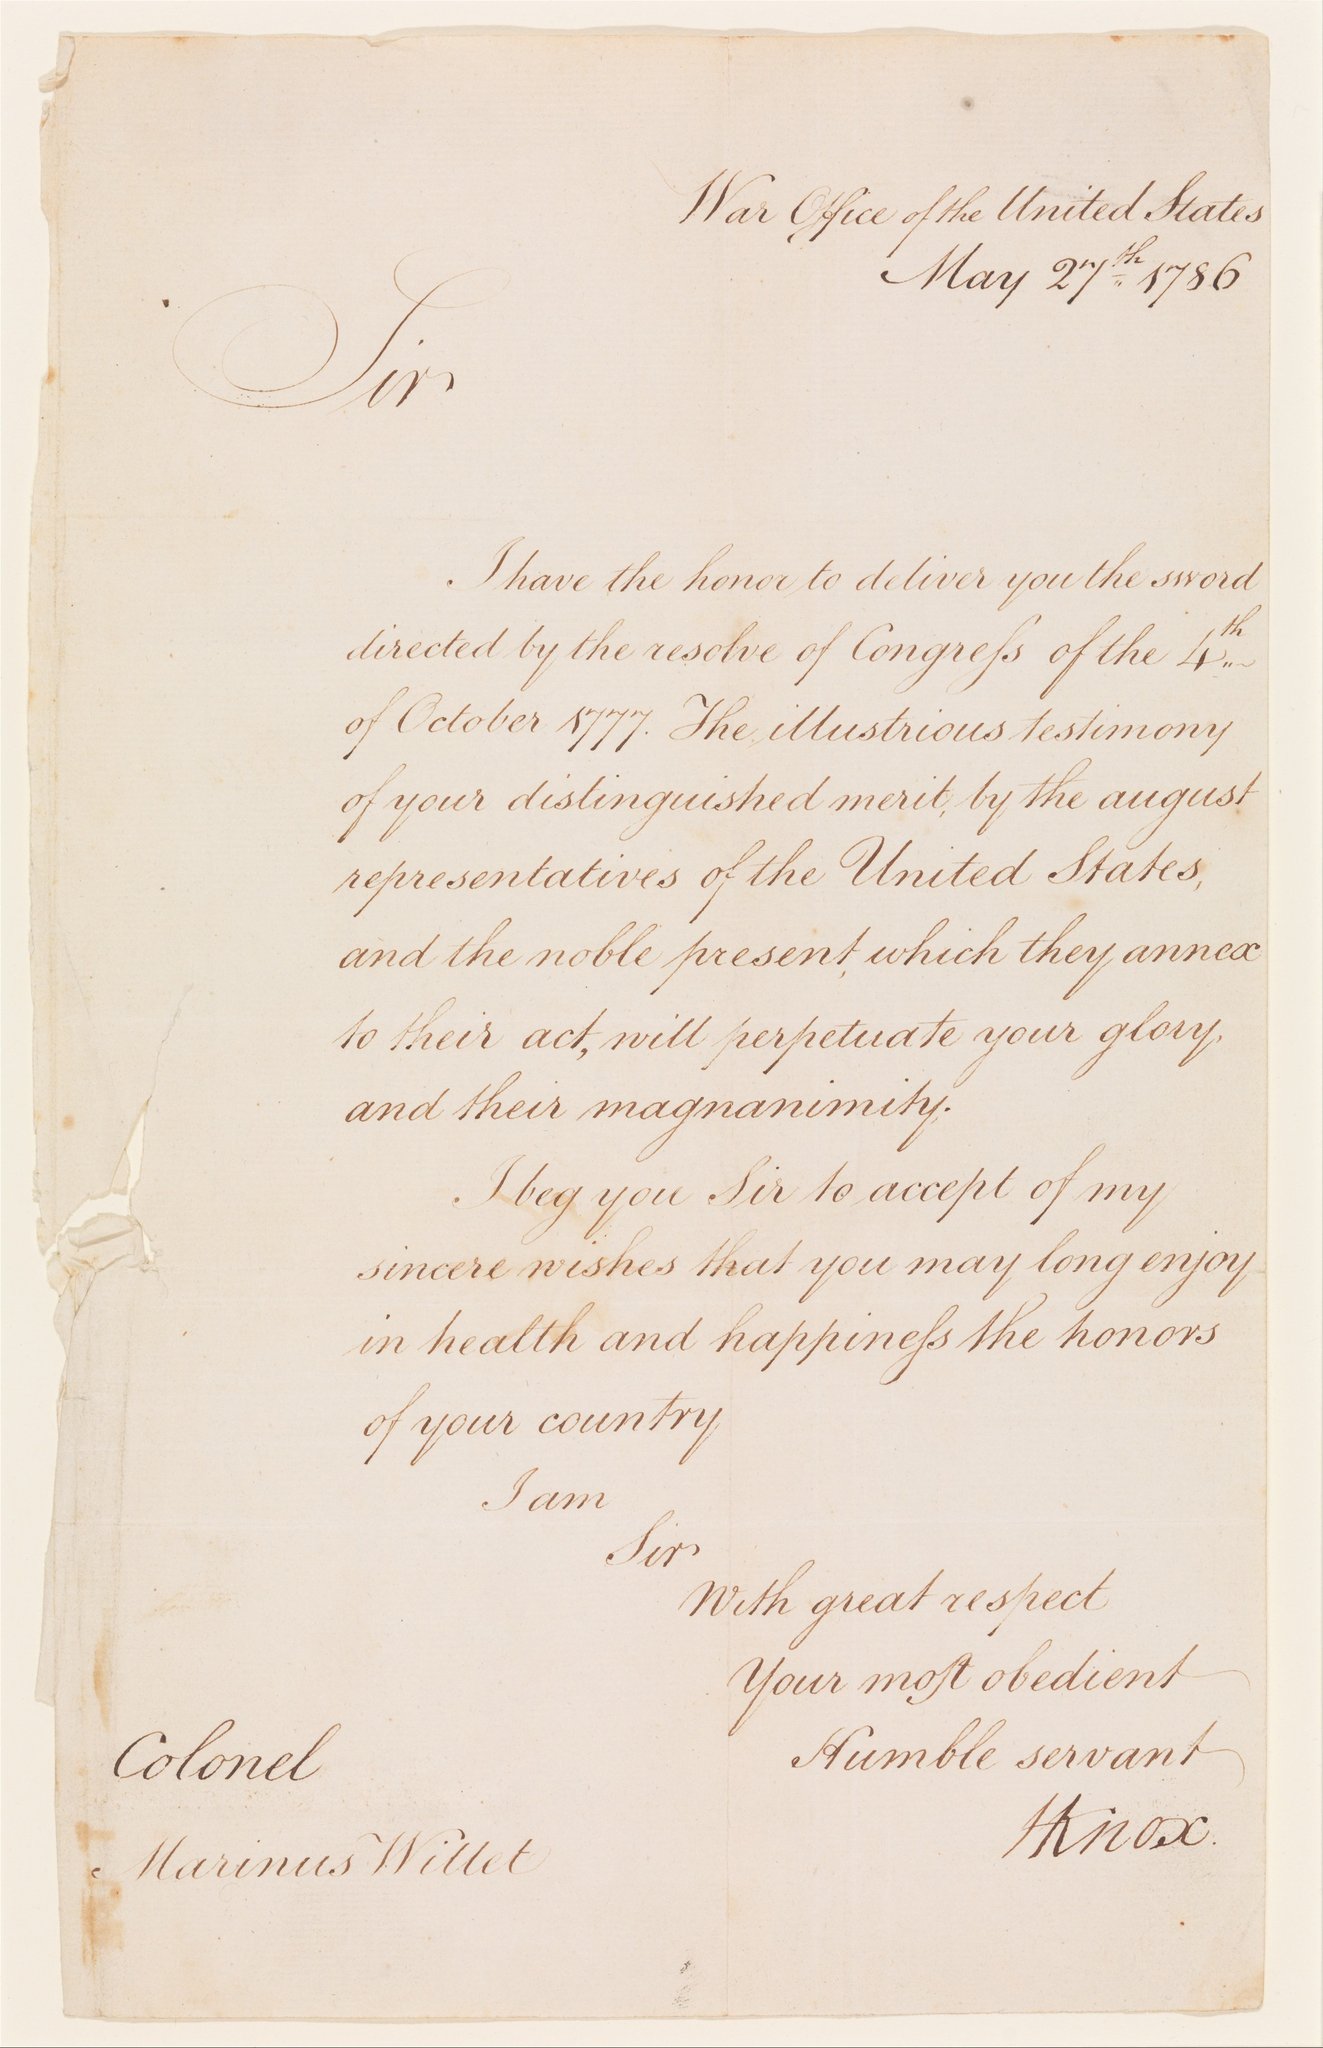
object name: letter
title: Letter from Henry Knox (1750–1806), Secretary of War, to Colonel Marinus Willett (1740–1830)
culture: american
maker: general henry knox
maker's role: author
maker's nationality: american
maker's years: 1750-1806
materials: ink, paper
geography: united states